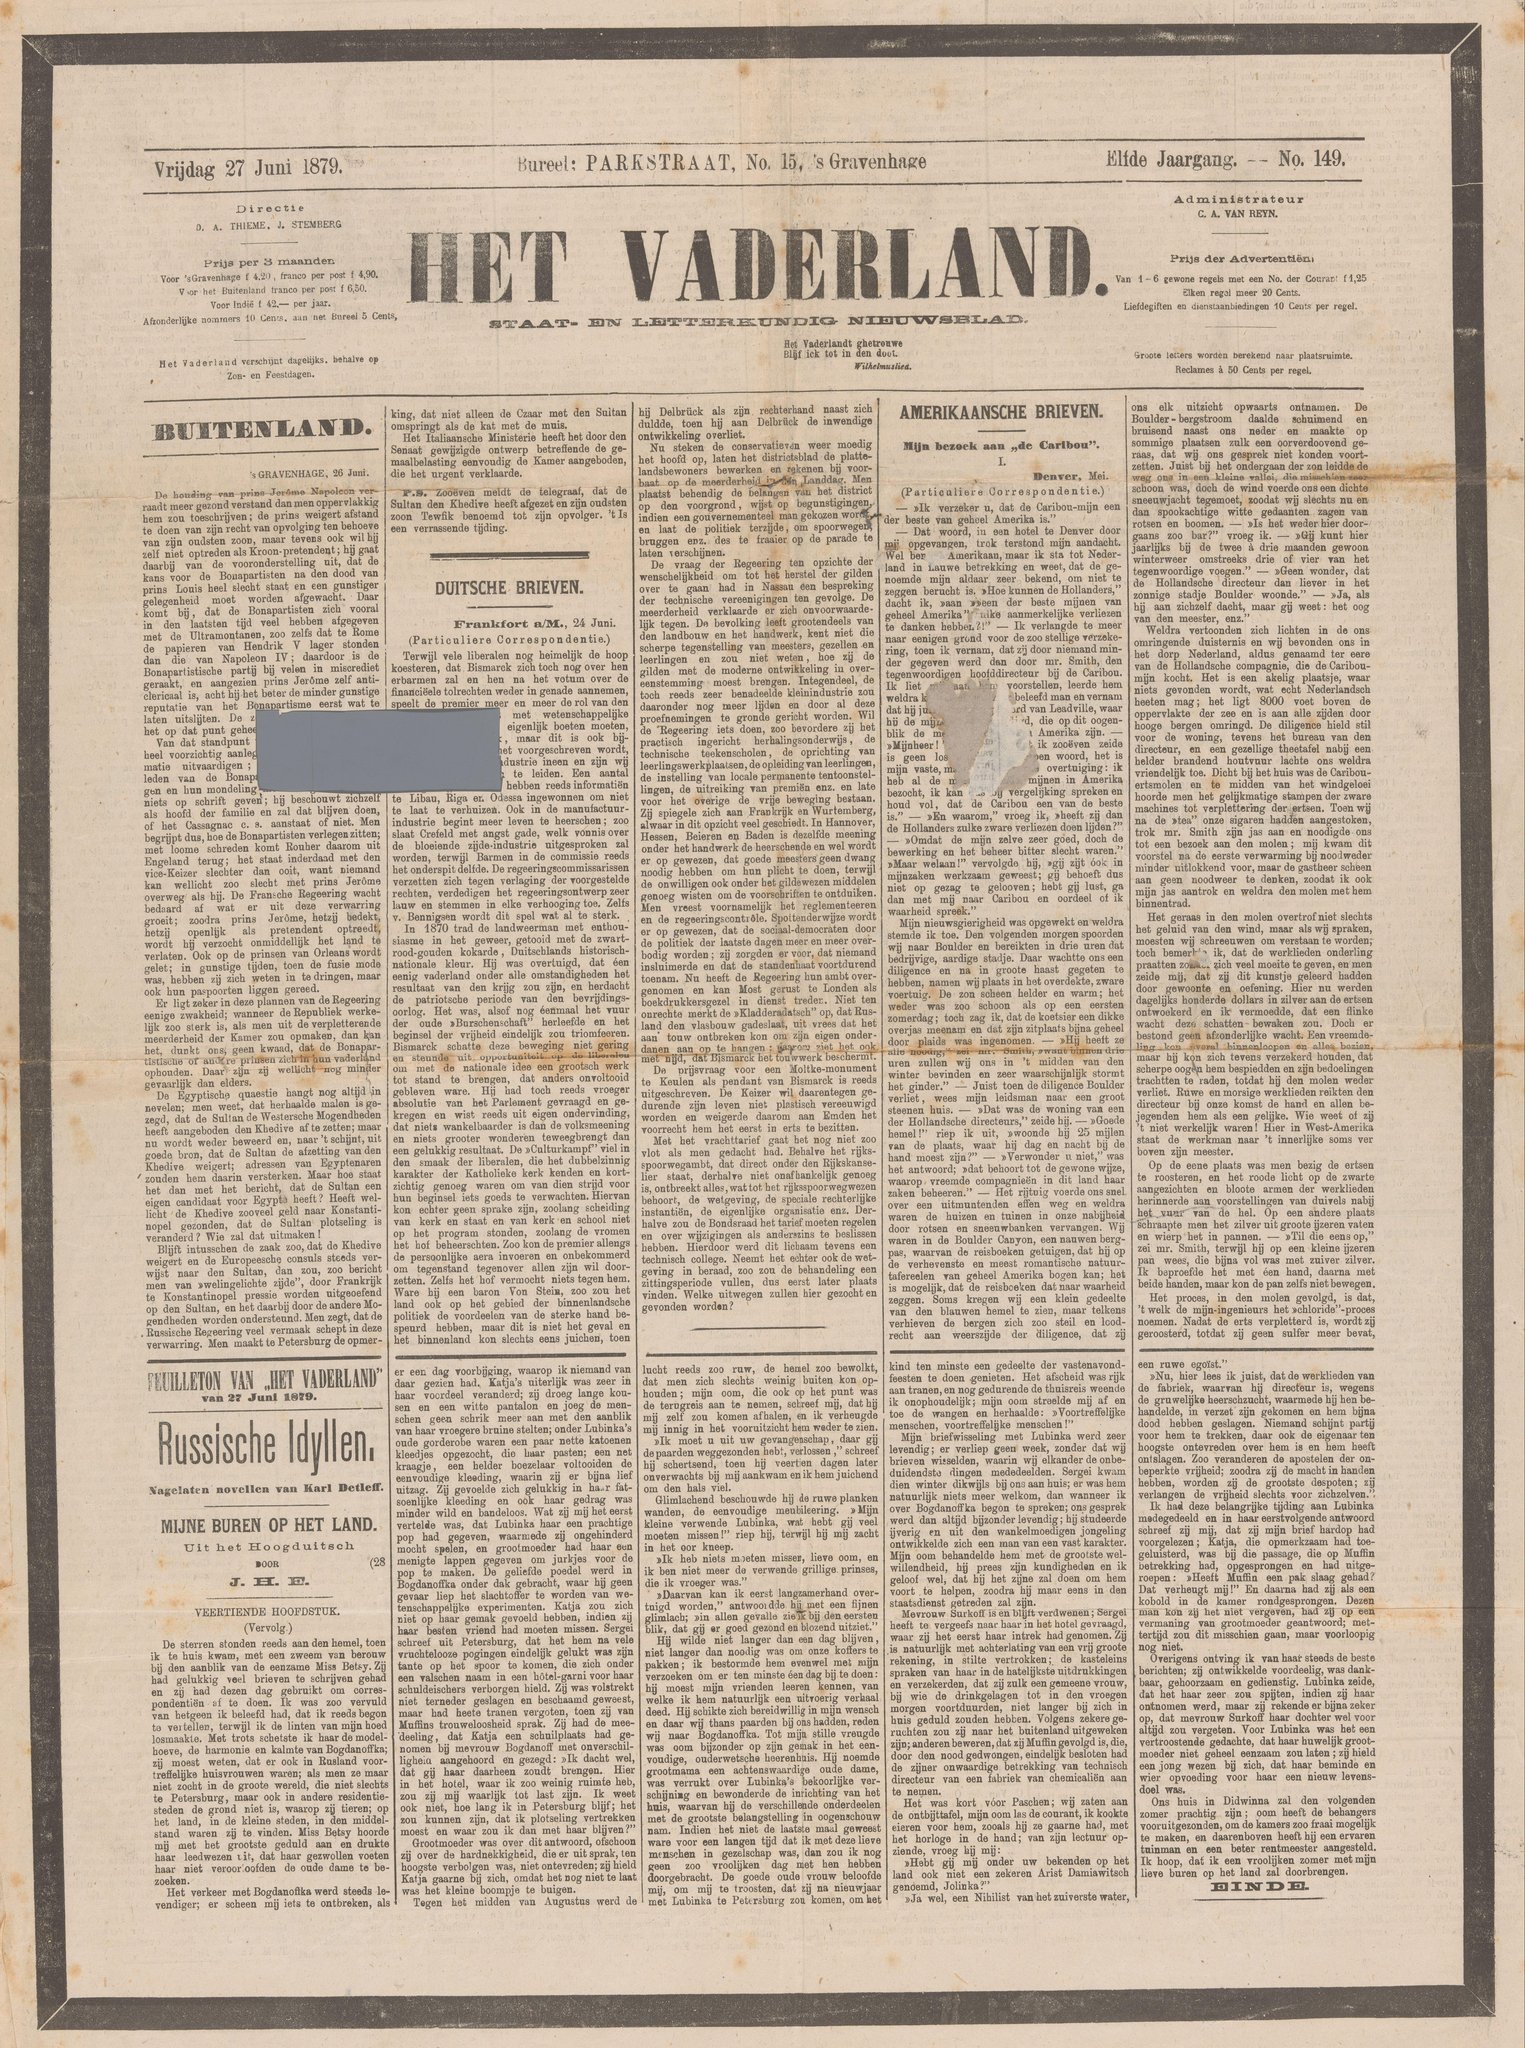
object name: newspaper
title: Het Vaderland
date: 1879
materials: paper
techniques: printing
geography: the hague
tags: hendrik (prins der nederlanden), netherlands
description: Krant nr. 149 van de 11e jaargang van "Het Vaderland", 1 blad, 2 pp voorzijde met gemengde berichten zwart omkaderd, achterzijde grotendeels gevuld met een verslag van de "Plechtige begrafenis van wijlen Zijne Koninklijke Hoogheid Willem Nicolaas Alexander Frederik Karel Hendrik, Prins van Oranje.